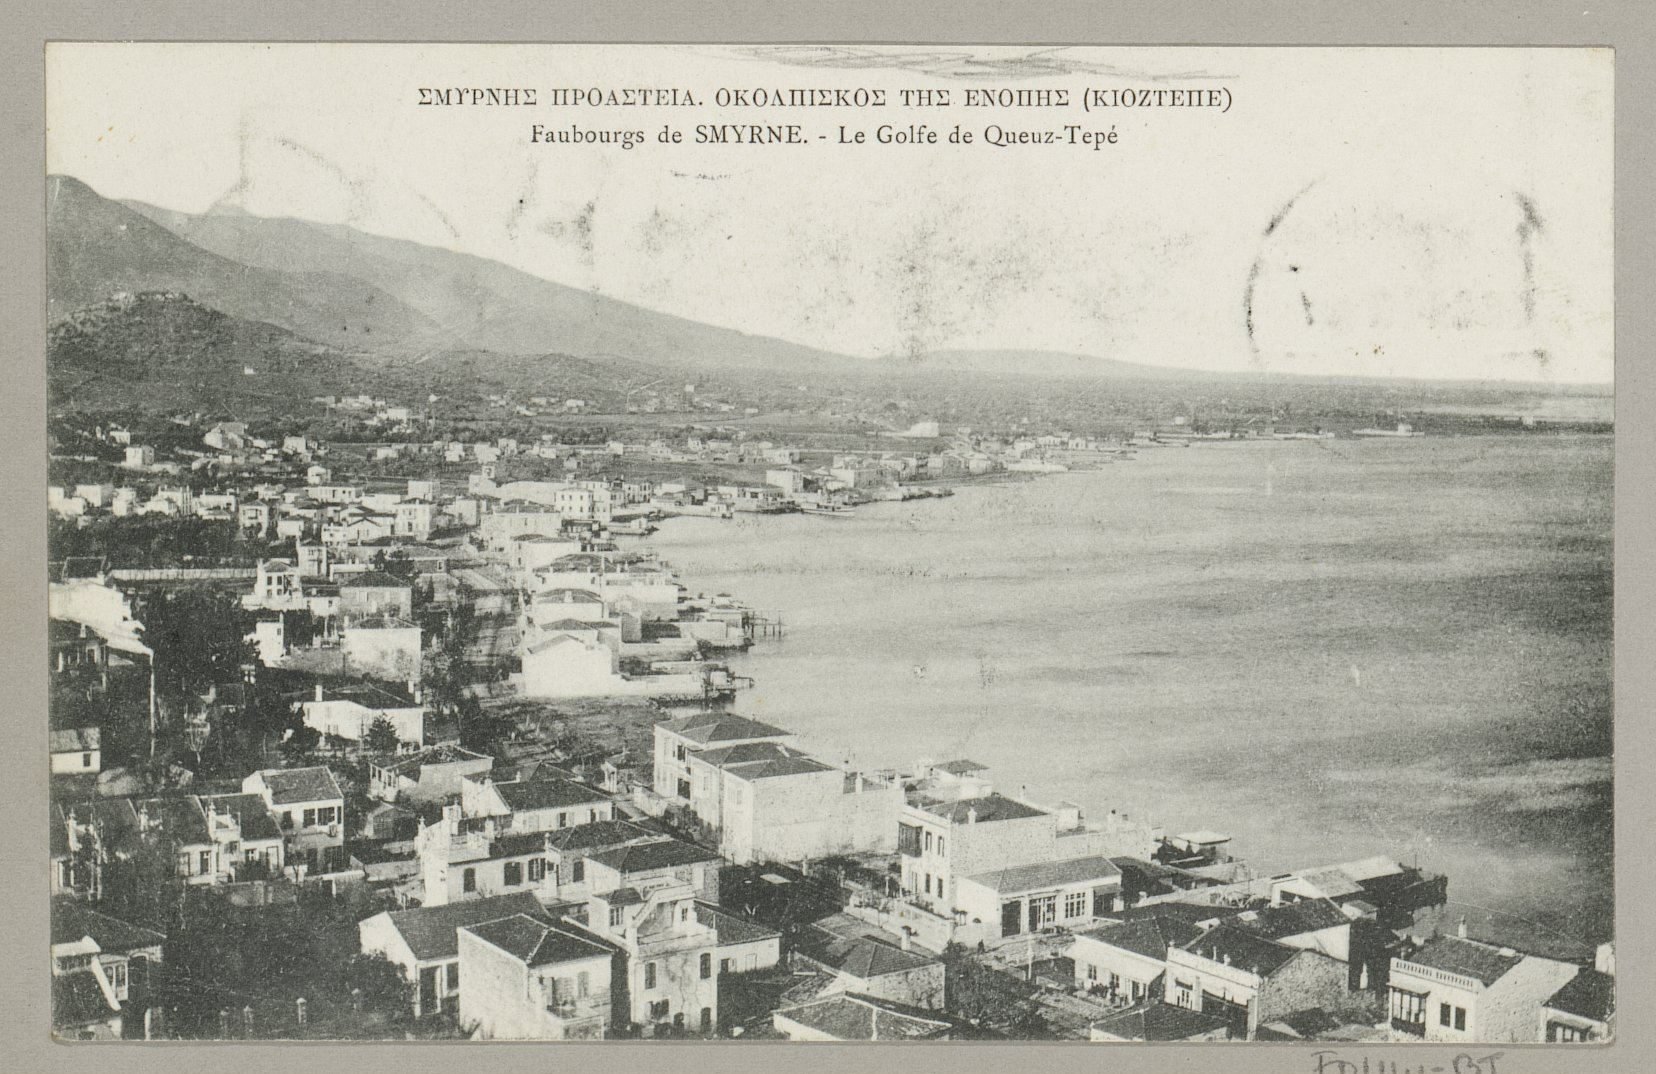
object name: ansichtkaart, prentbriefkaart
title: Faubourgs de SMYRNE. Le Golfe de Queuz-Tepé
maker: Anonymous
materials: paper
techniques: photograph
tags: gulf, bay (+ landscape with figures, staffage), prospect of city, town panorama, silhouette of city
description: Onderdeel van Fotoalbum van een reis door Zuid-Europa en het Midden-Oosten.